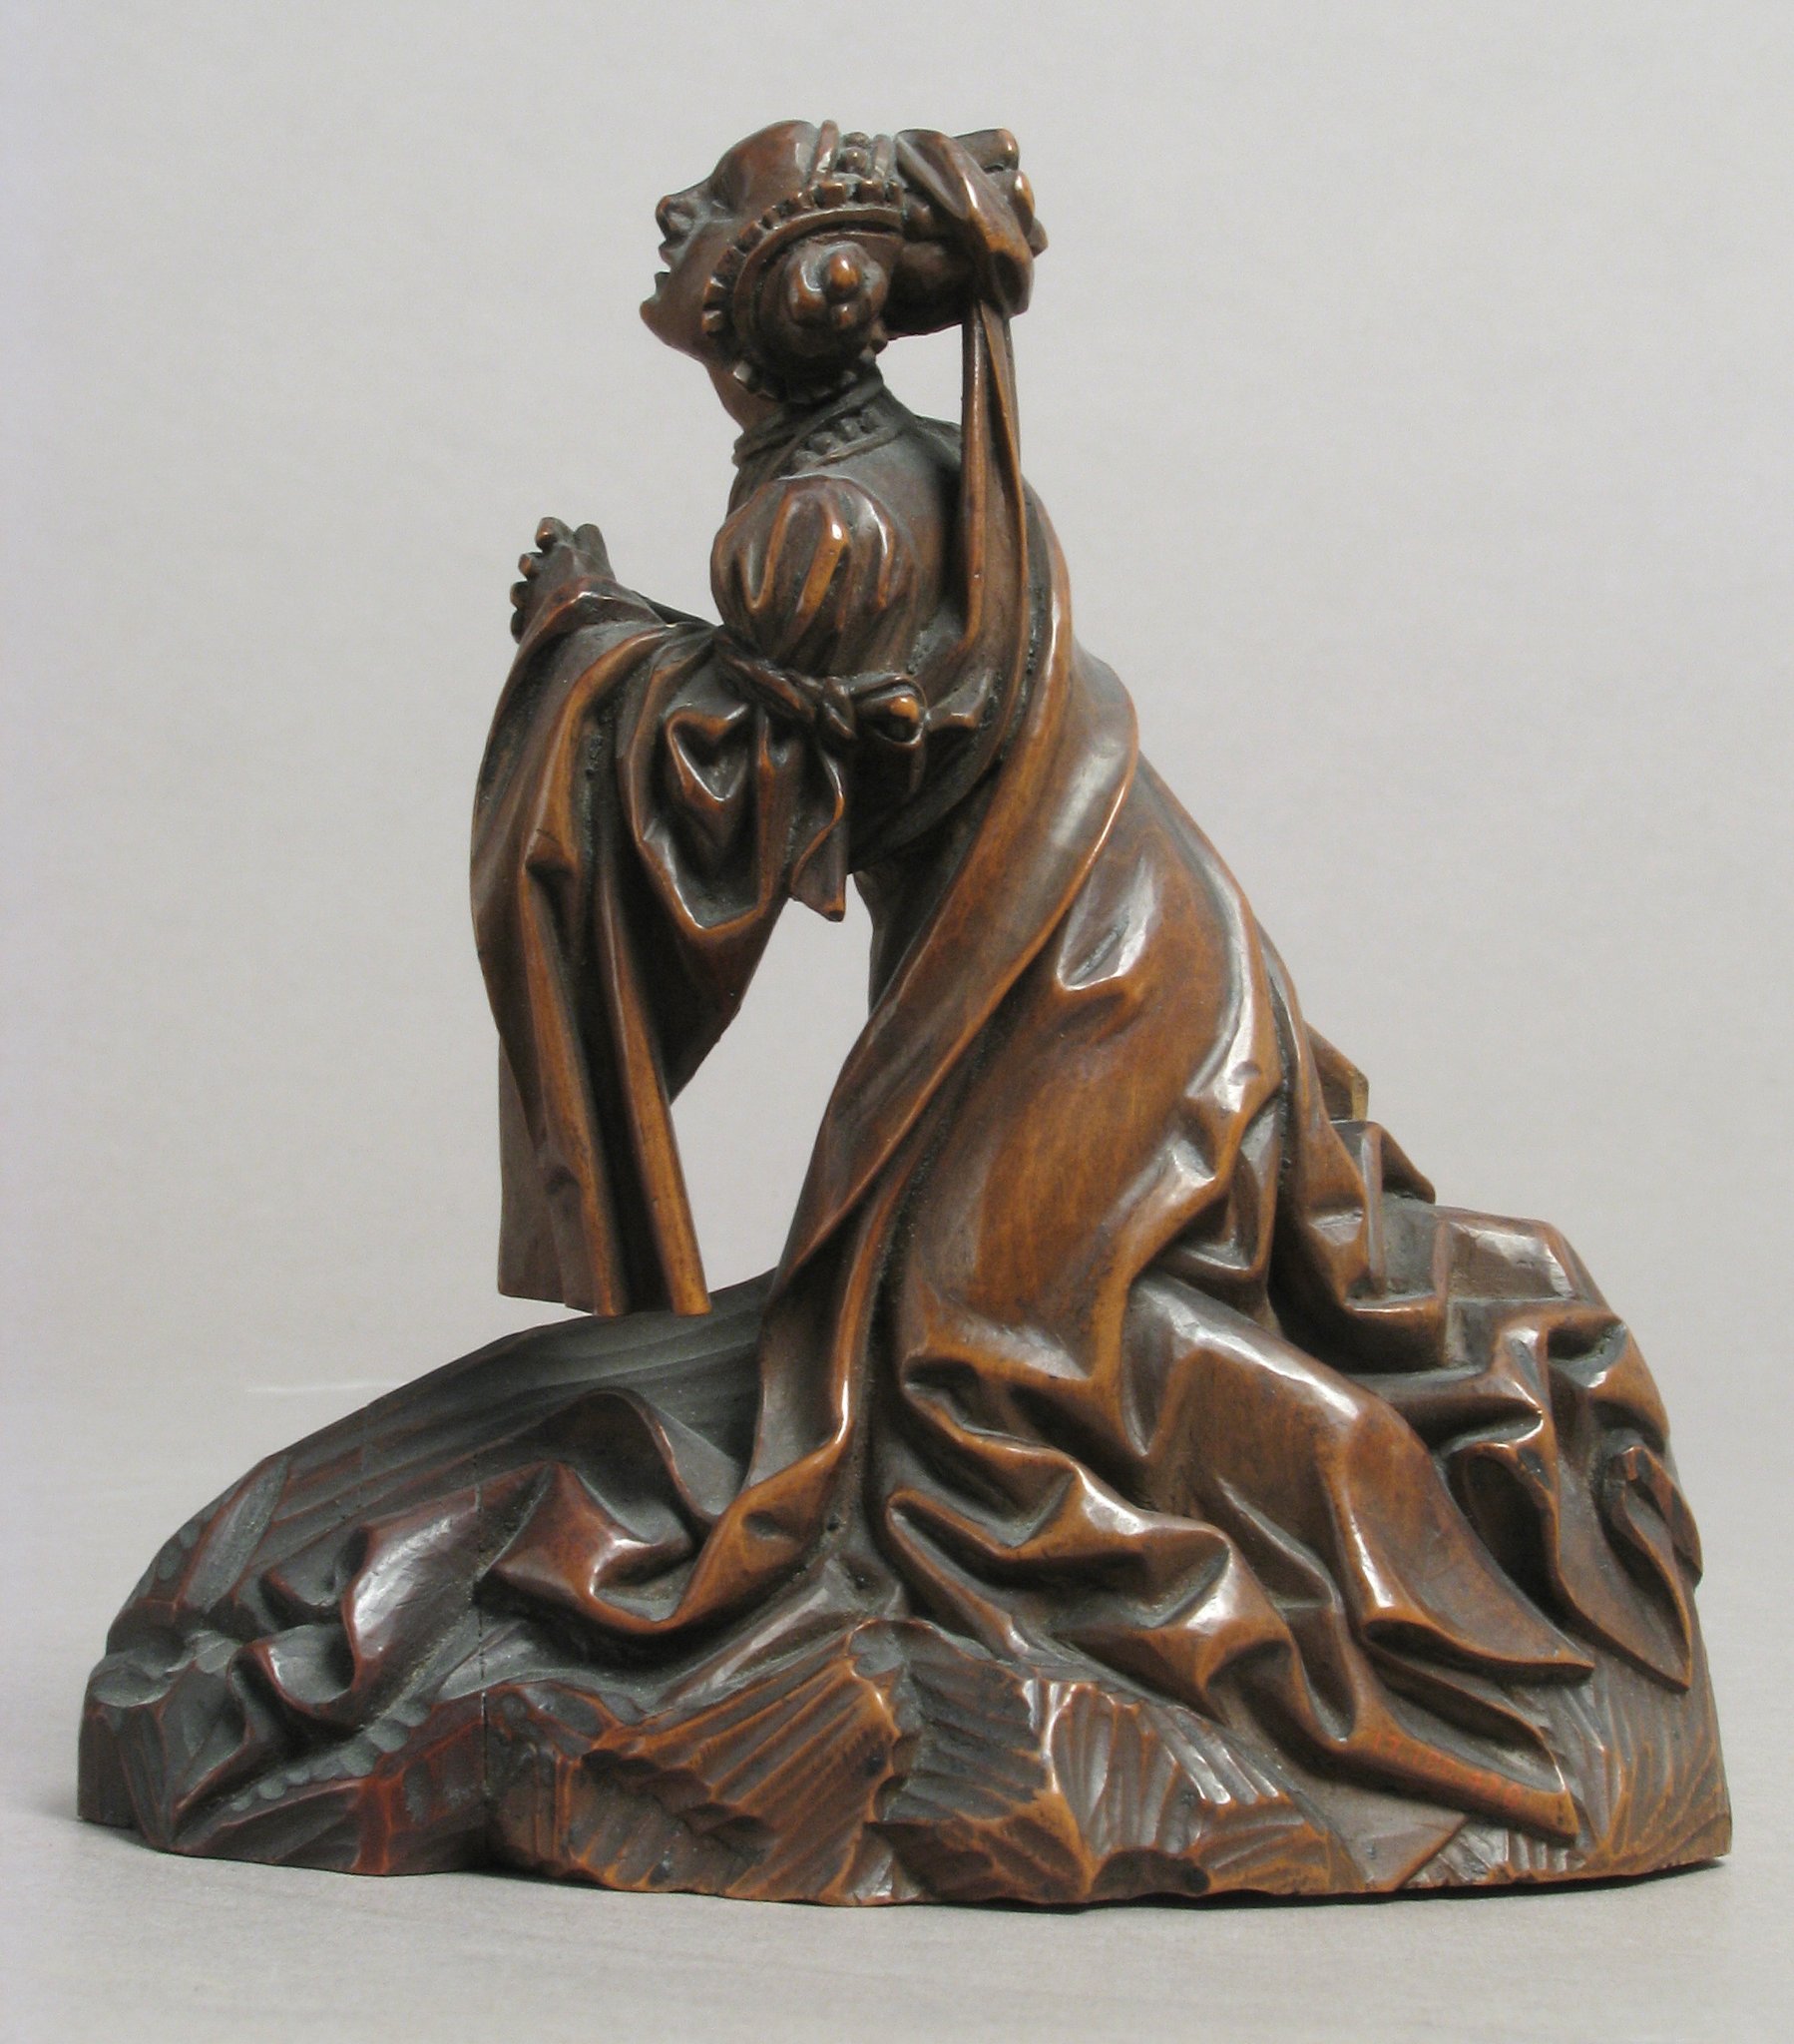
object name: relief statue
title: Saint Mary Magdalene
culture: german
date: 1501-1600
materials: wood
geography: germany